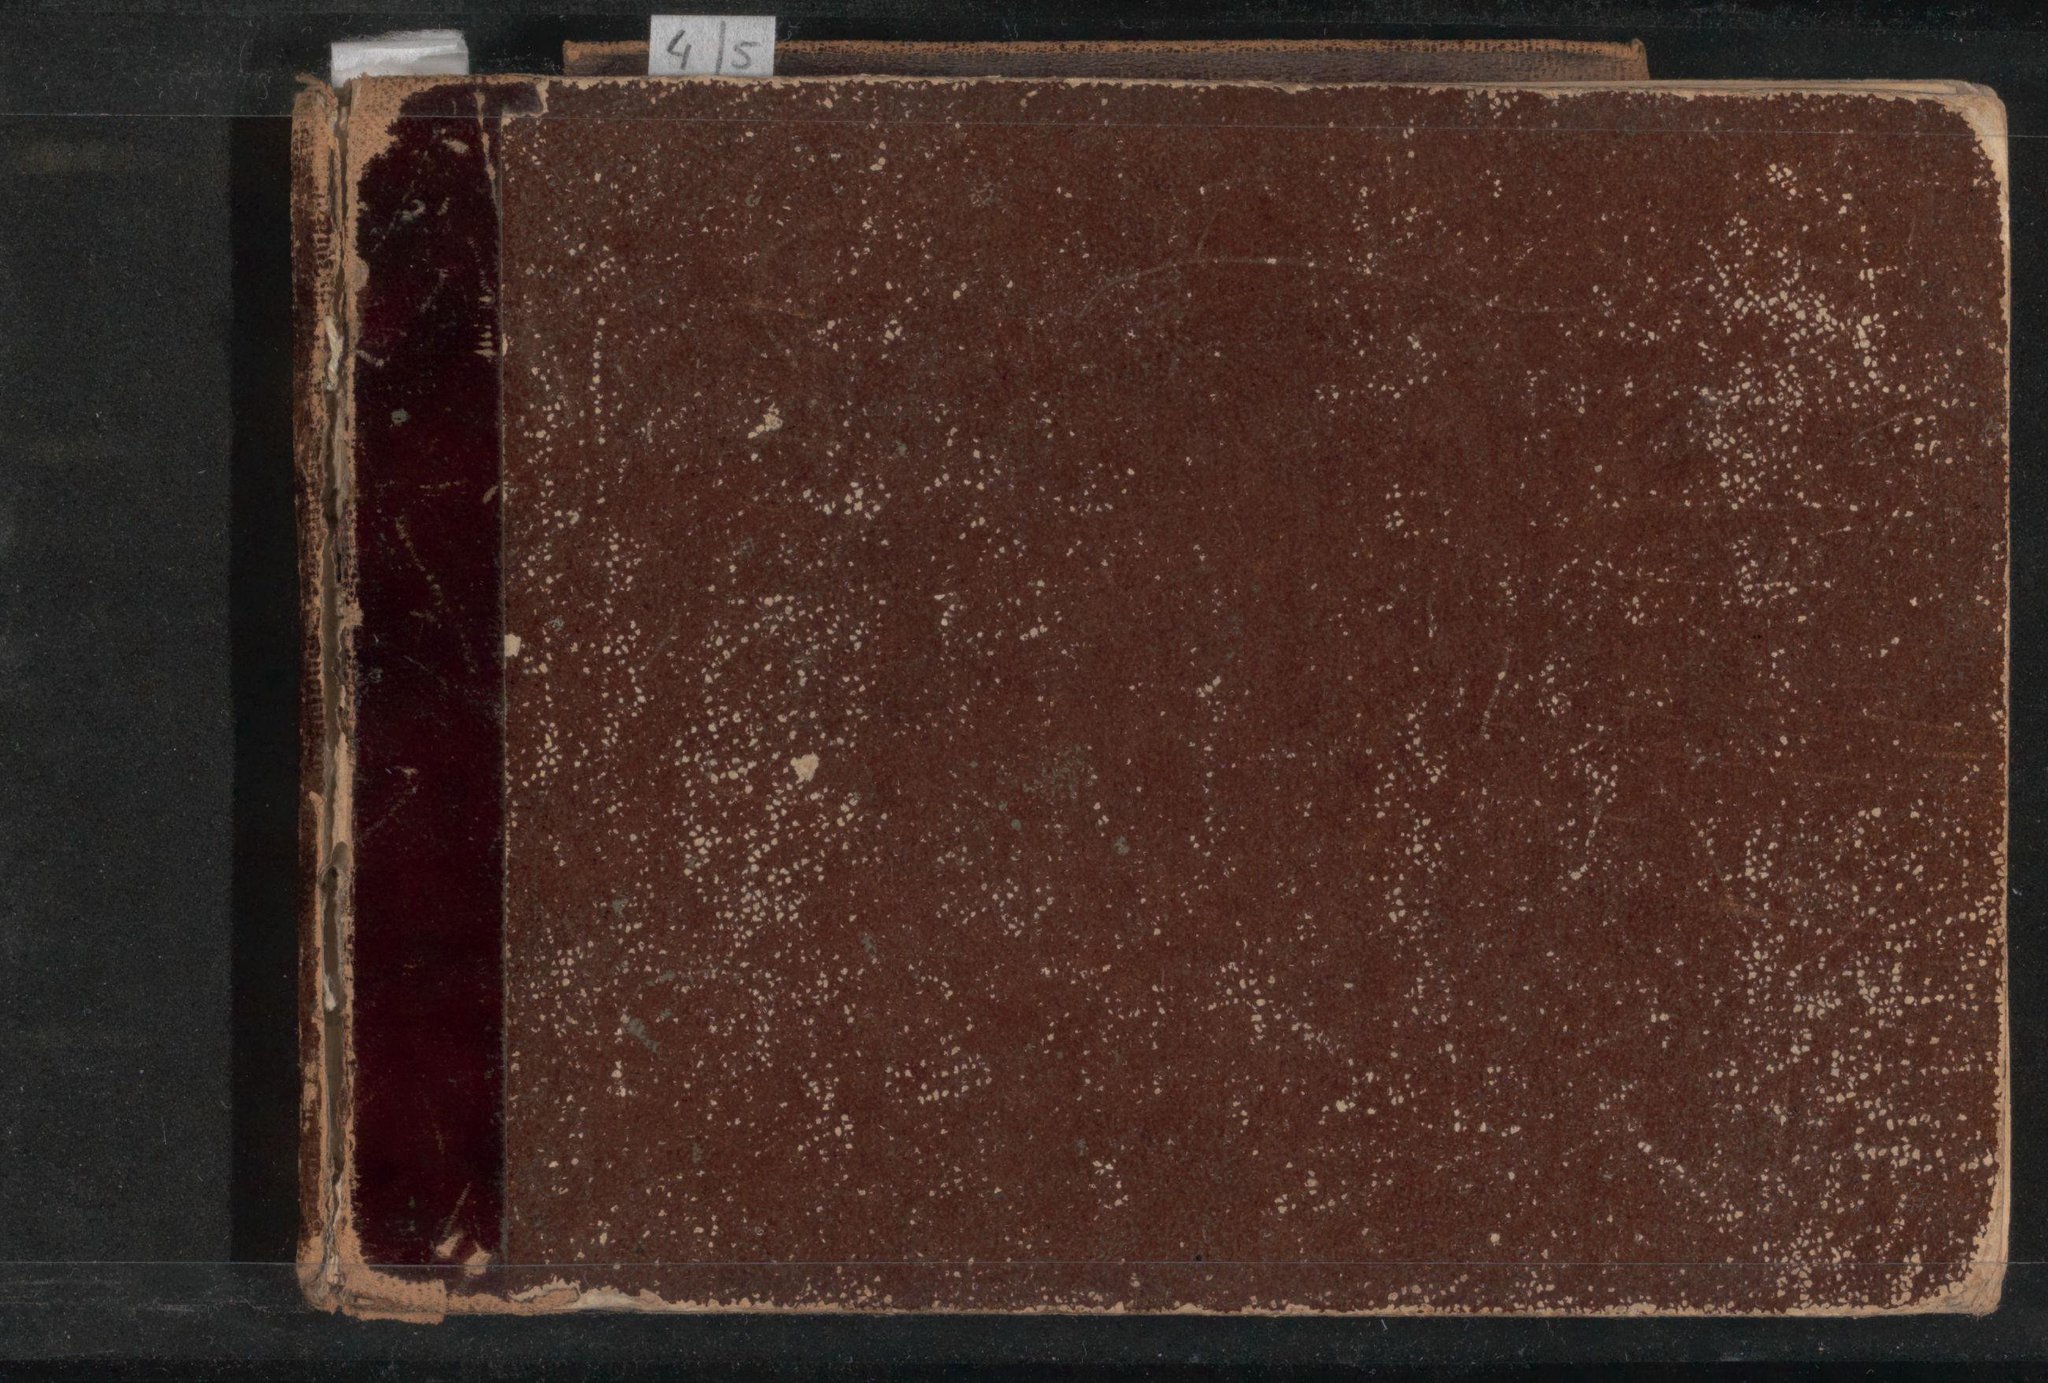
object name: sketchbook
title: Schetsboek met 30 bladen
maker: maria vos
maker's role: draughtsman, painter, print maker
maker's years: 1824-1906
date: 1834-1906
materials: cardboard, leather, paper, pencil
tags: plants (in general), city-view, and landscape with man-made constructions, landscapes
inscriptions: collector's mark: Lugt L2228a, number: ‘No. 2.’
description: Schetsboek bestaande uit 30 bladen met voornamelijk landschappen, stadsgezichten, bomen, planten en dieren.